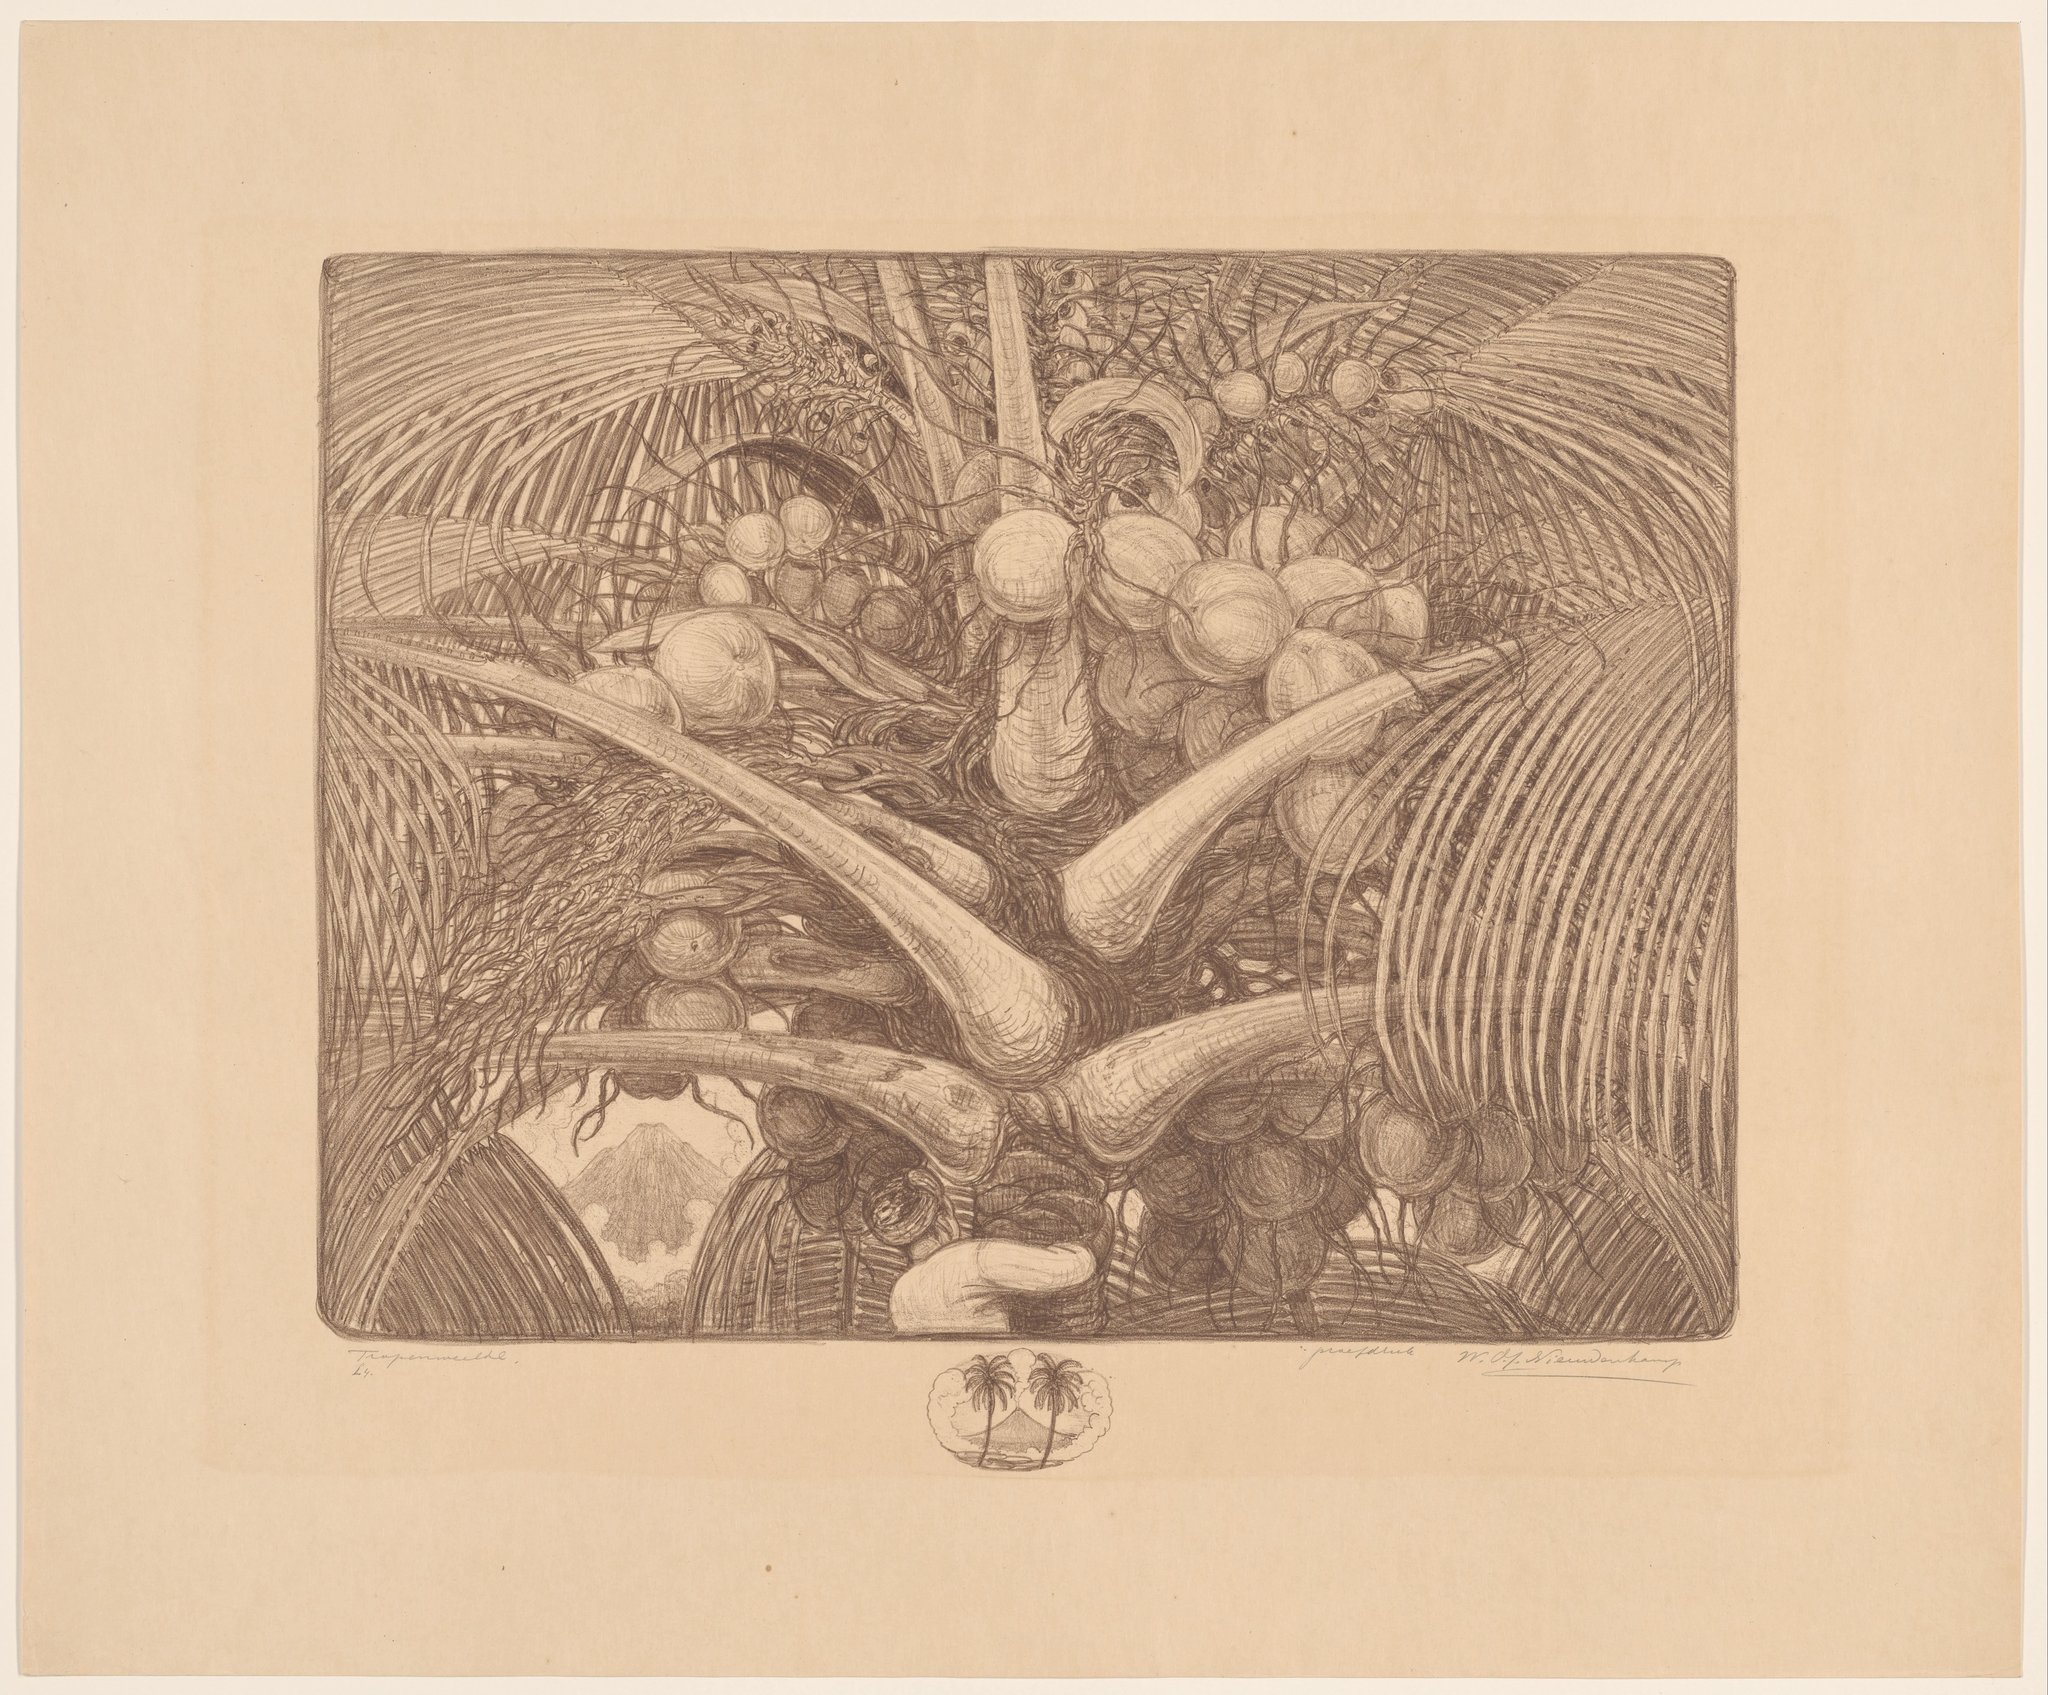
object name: print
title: Tropenweelde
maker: wijnand otto jan nieuwenkamp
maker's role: draughtsman, print maker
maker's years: 1874-1950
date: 1902-1918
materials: paper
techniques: lithograph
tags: trees: coconut-tree, dutch east indies, the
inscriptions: collector's mark: Lugt 2233